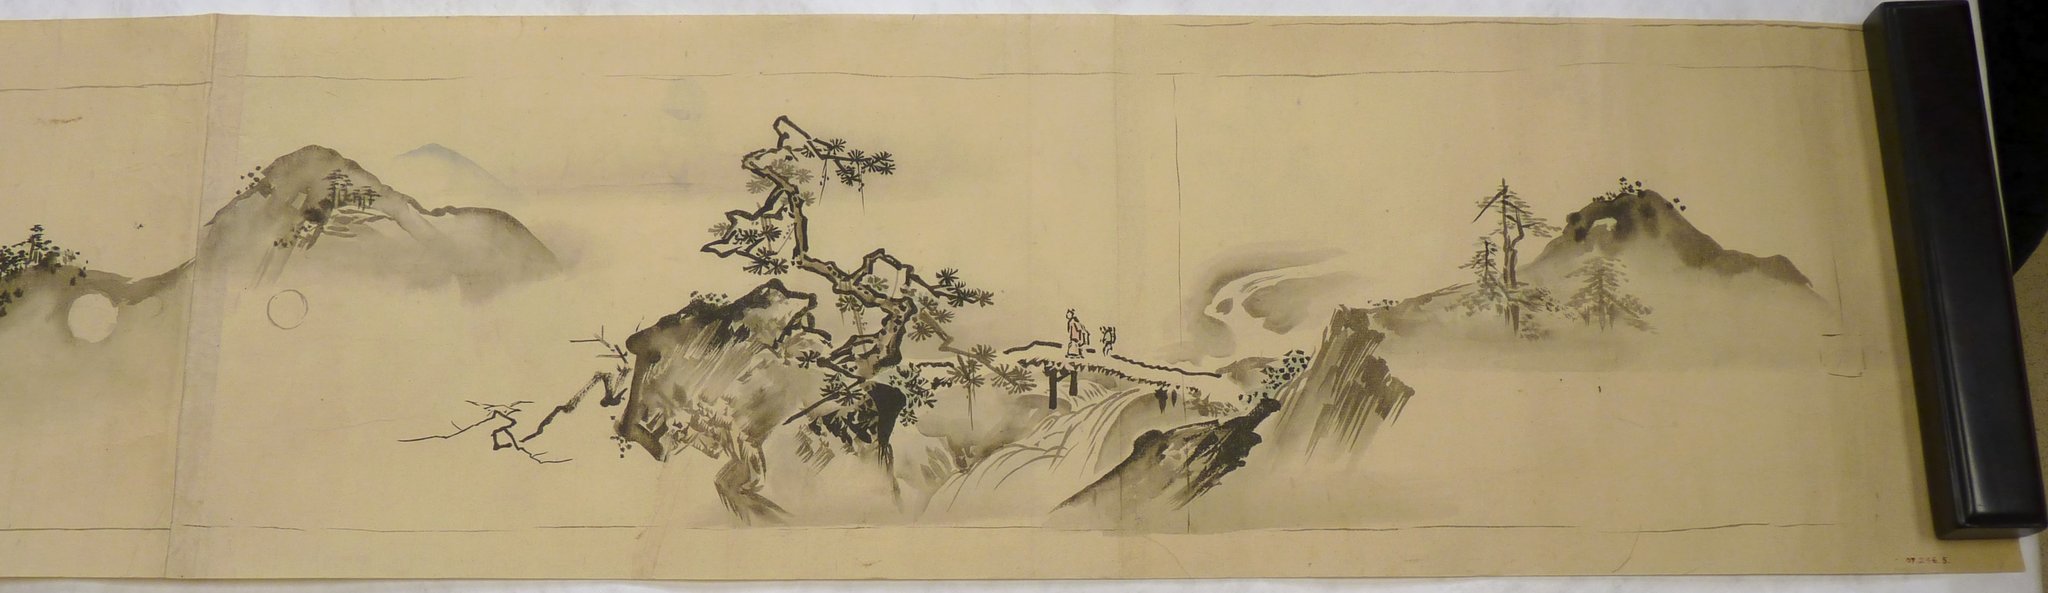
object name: drawing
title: Japanese Drawing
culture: japanese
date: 1801-1833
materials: paper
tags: mountains,landscapes